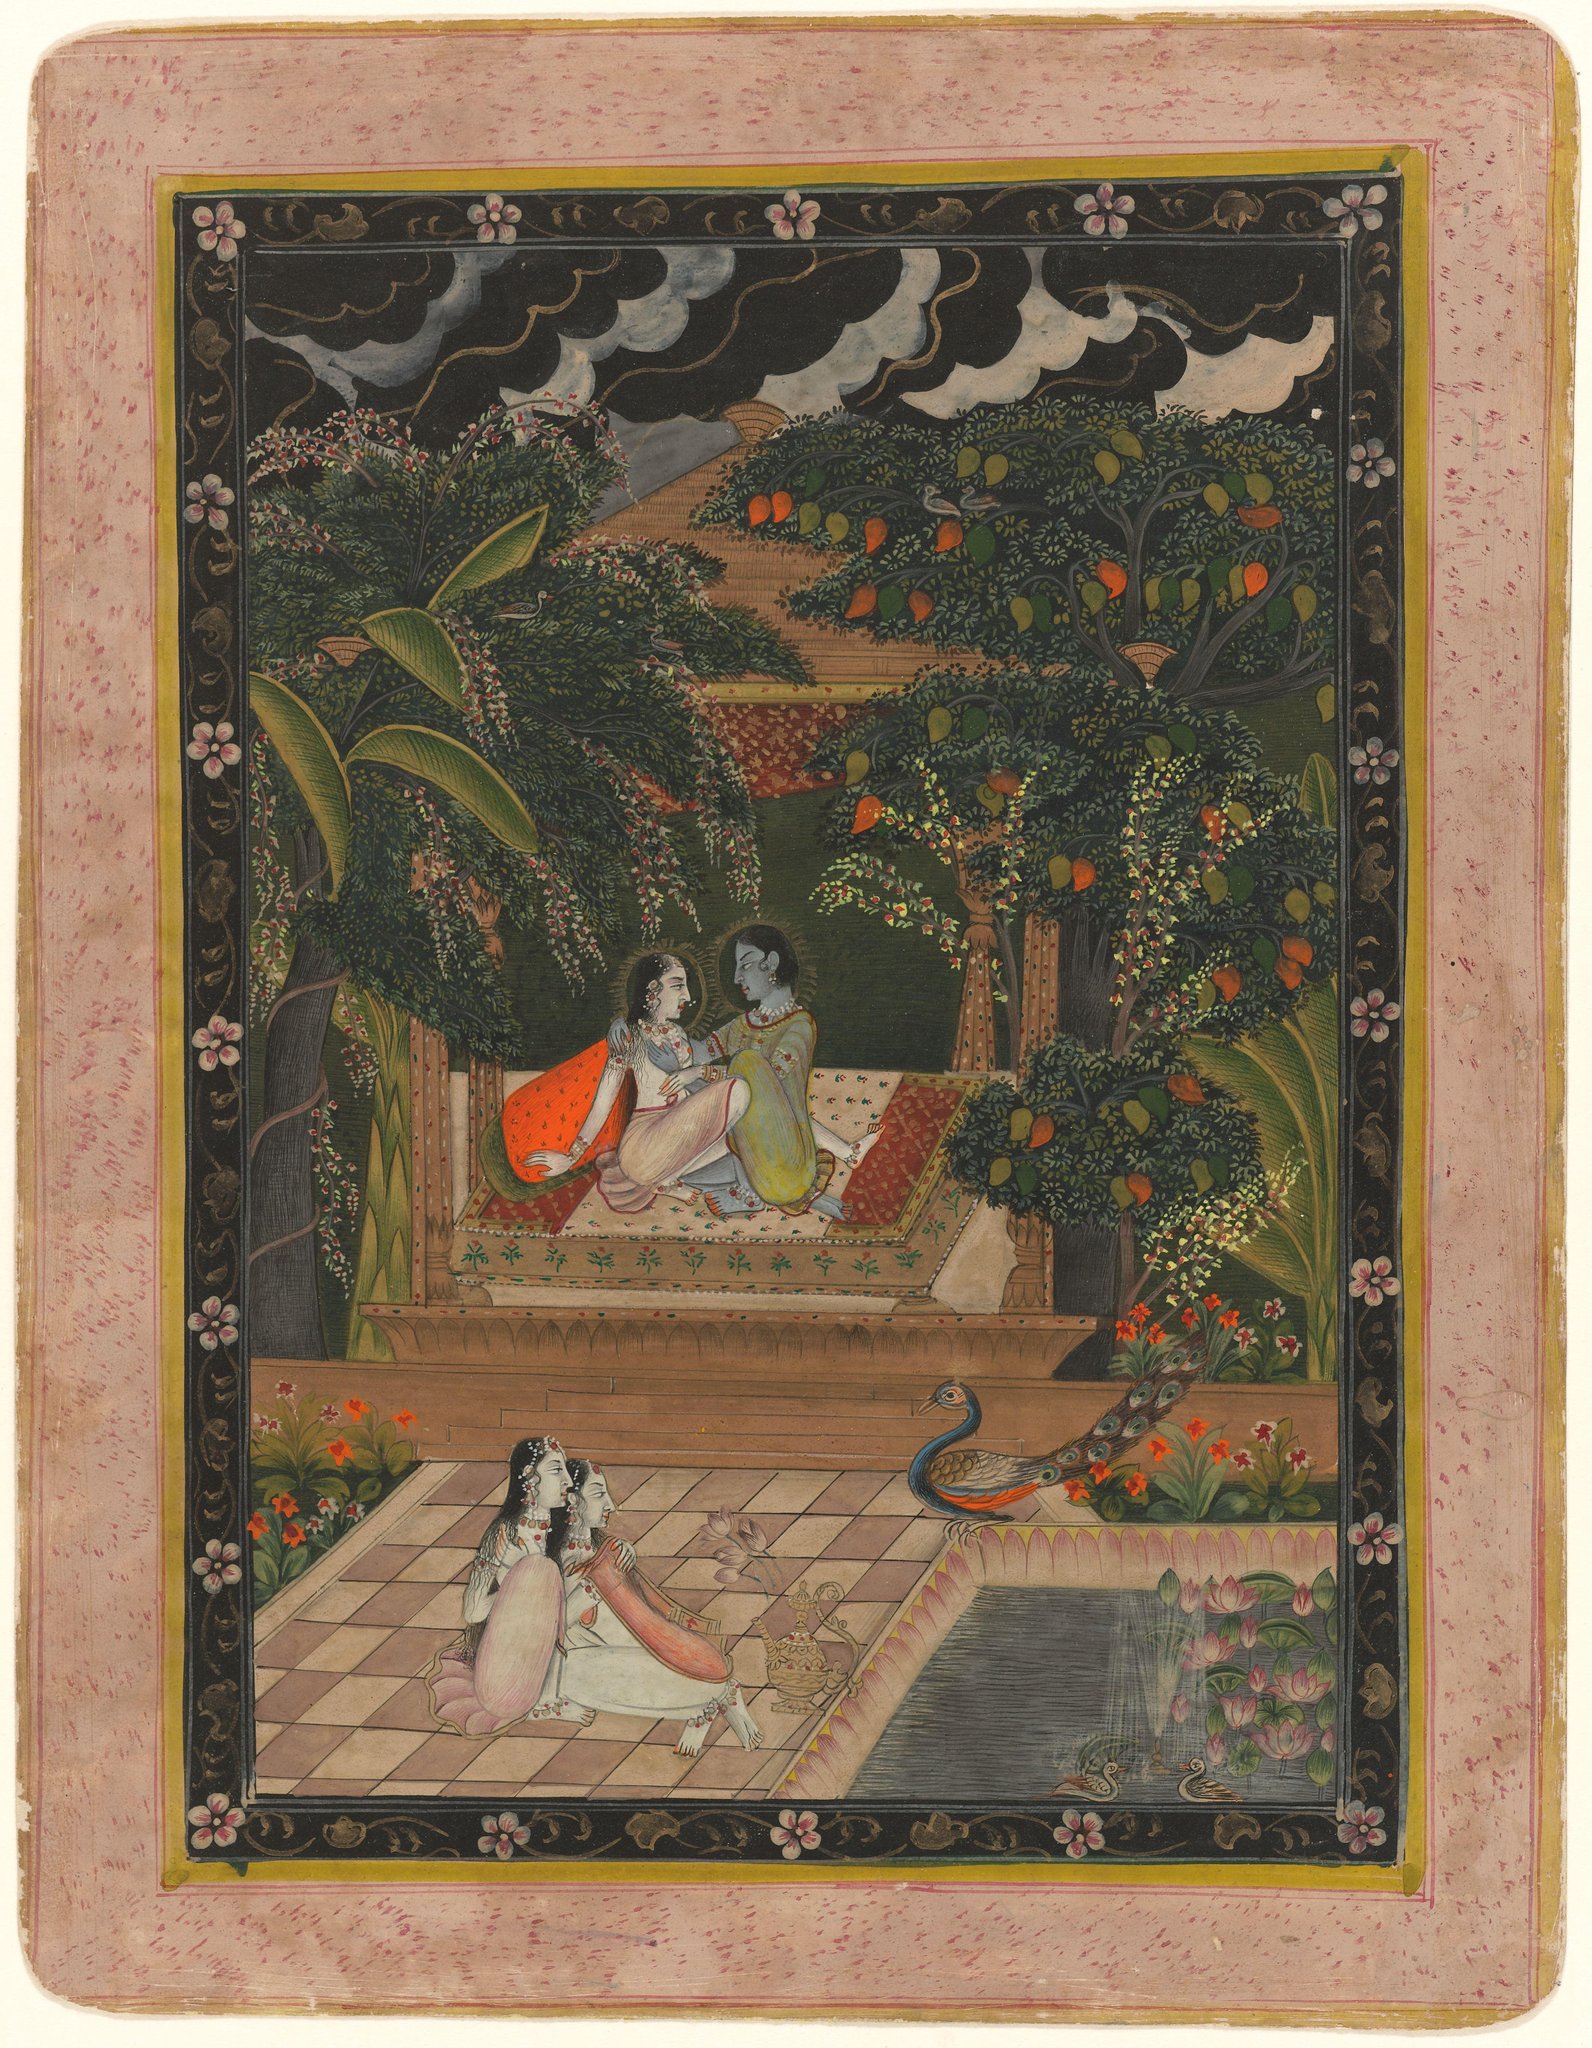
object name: drawing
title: Krishna en Radha op terras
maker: Anonymous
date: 1800-1949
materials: paint, paper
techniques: brush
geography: rajasthan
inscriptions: inscription: ‘.’